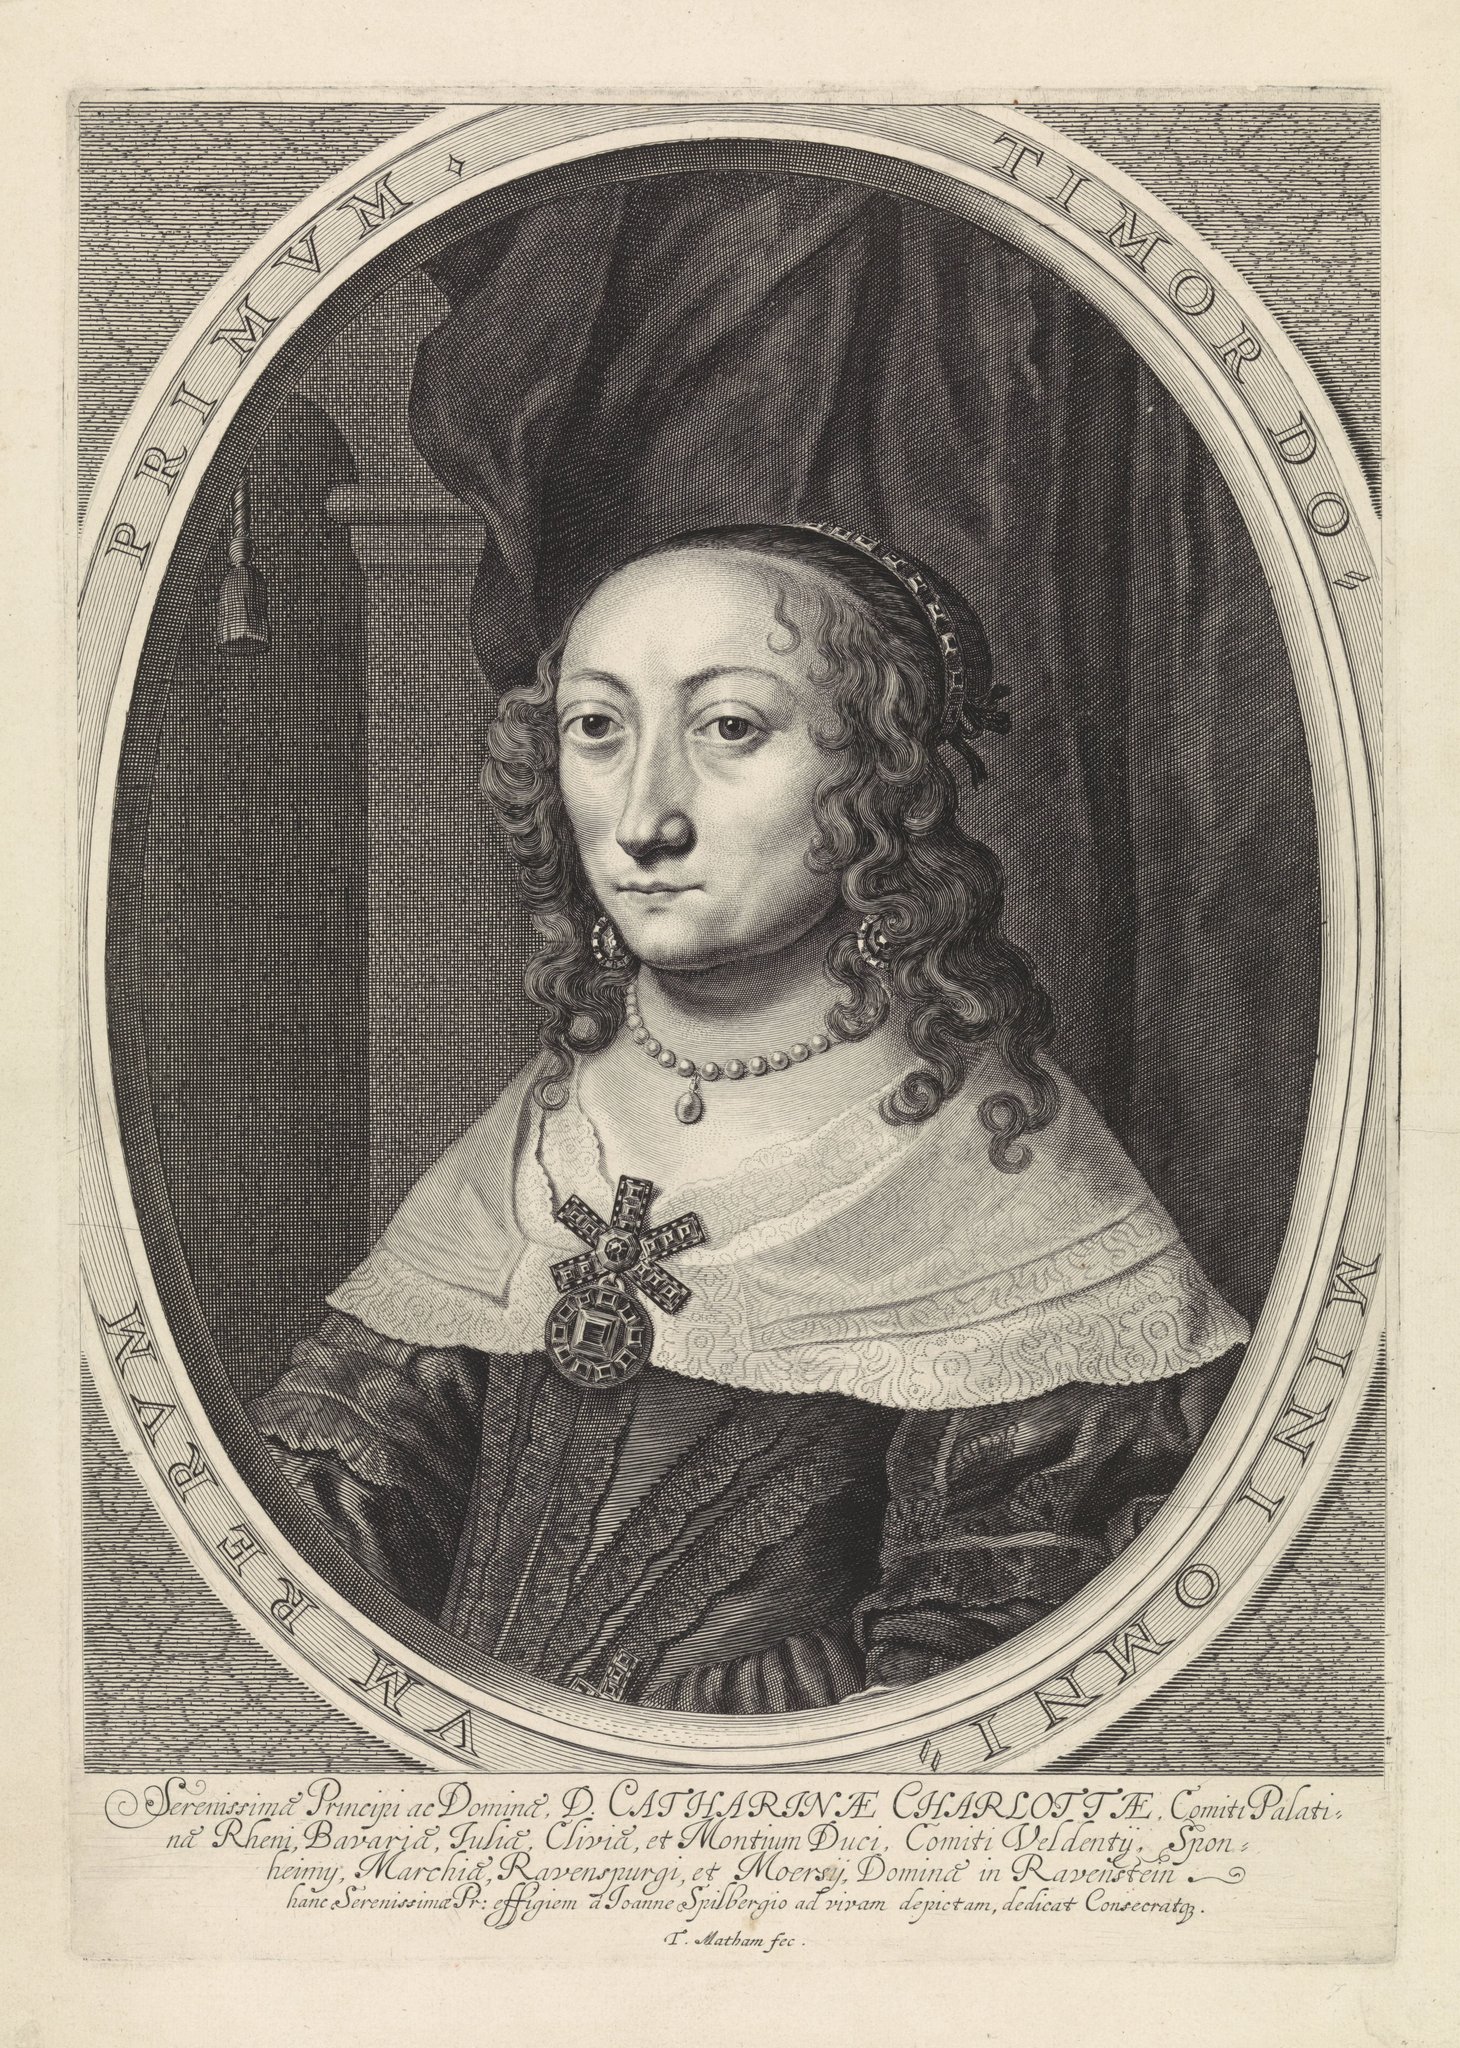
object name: print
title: Portret van Catherina Charlotta, paltsgravin van Palts-Neuburg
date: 1635-1653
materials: paper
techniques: engraving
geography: northern netherlands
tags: ornaments, jewels, pearl; pearl necklace (+ women's clothes)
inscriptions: collector's mark: Lugt 240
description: Portret van Catherina Charlotta, paltsgravin van Palts-Neuburg, vrouw van Wolfgang Willem van de Palts-Neuburg. Om haar hals een parelsnoer met een hanger en op haar borst een juwelen speld.